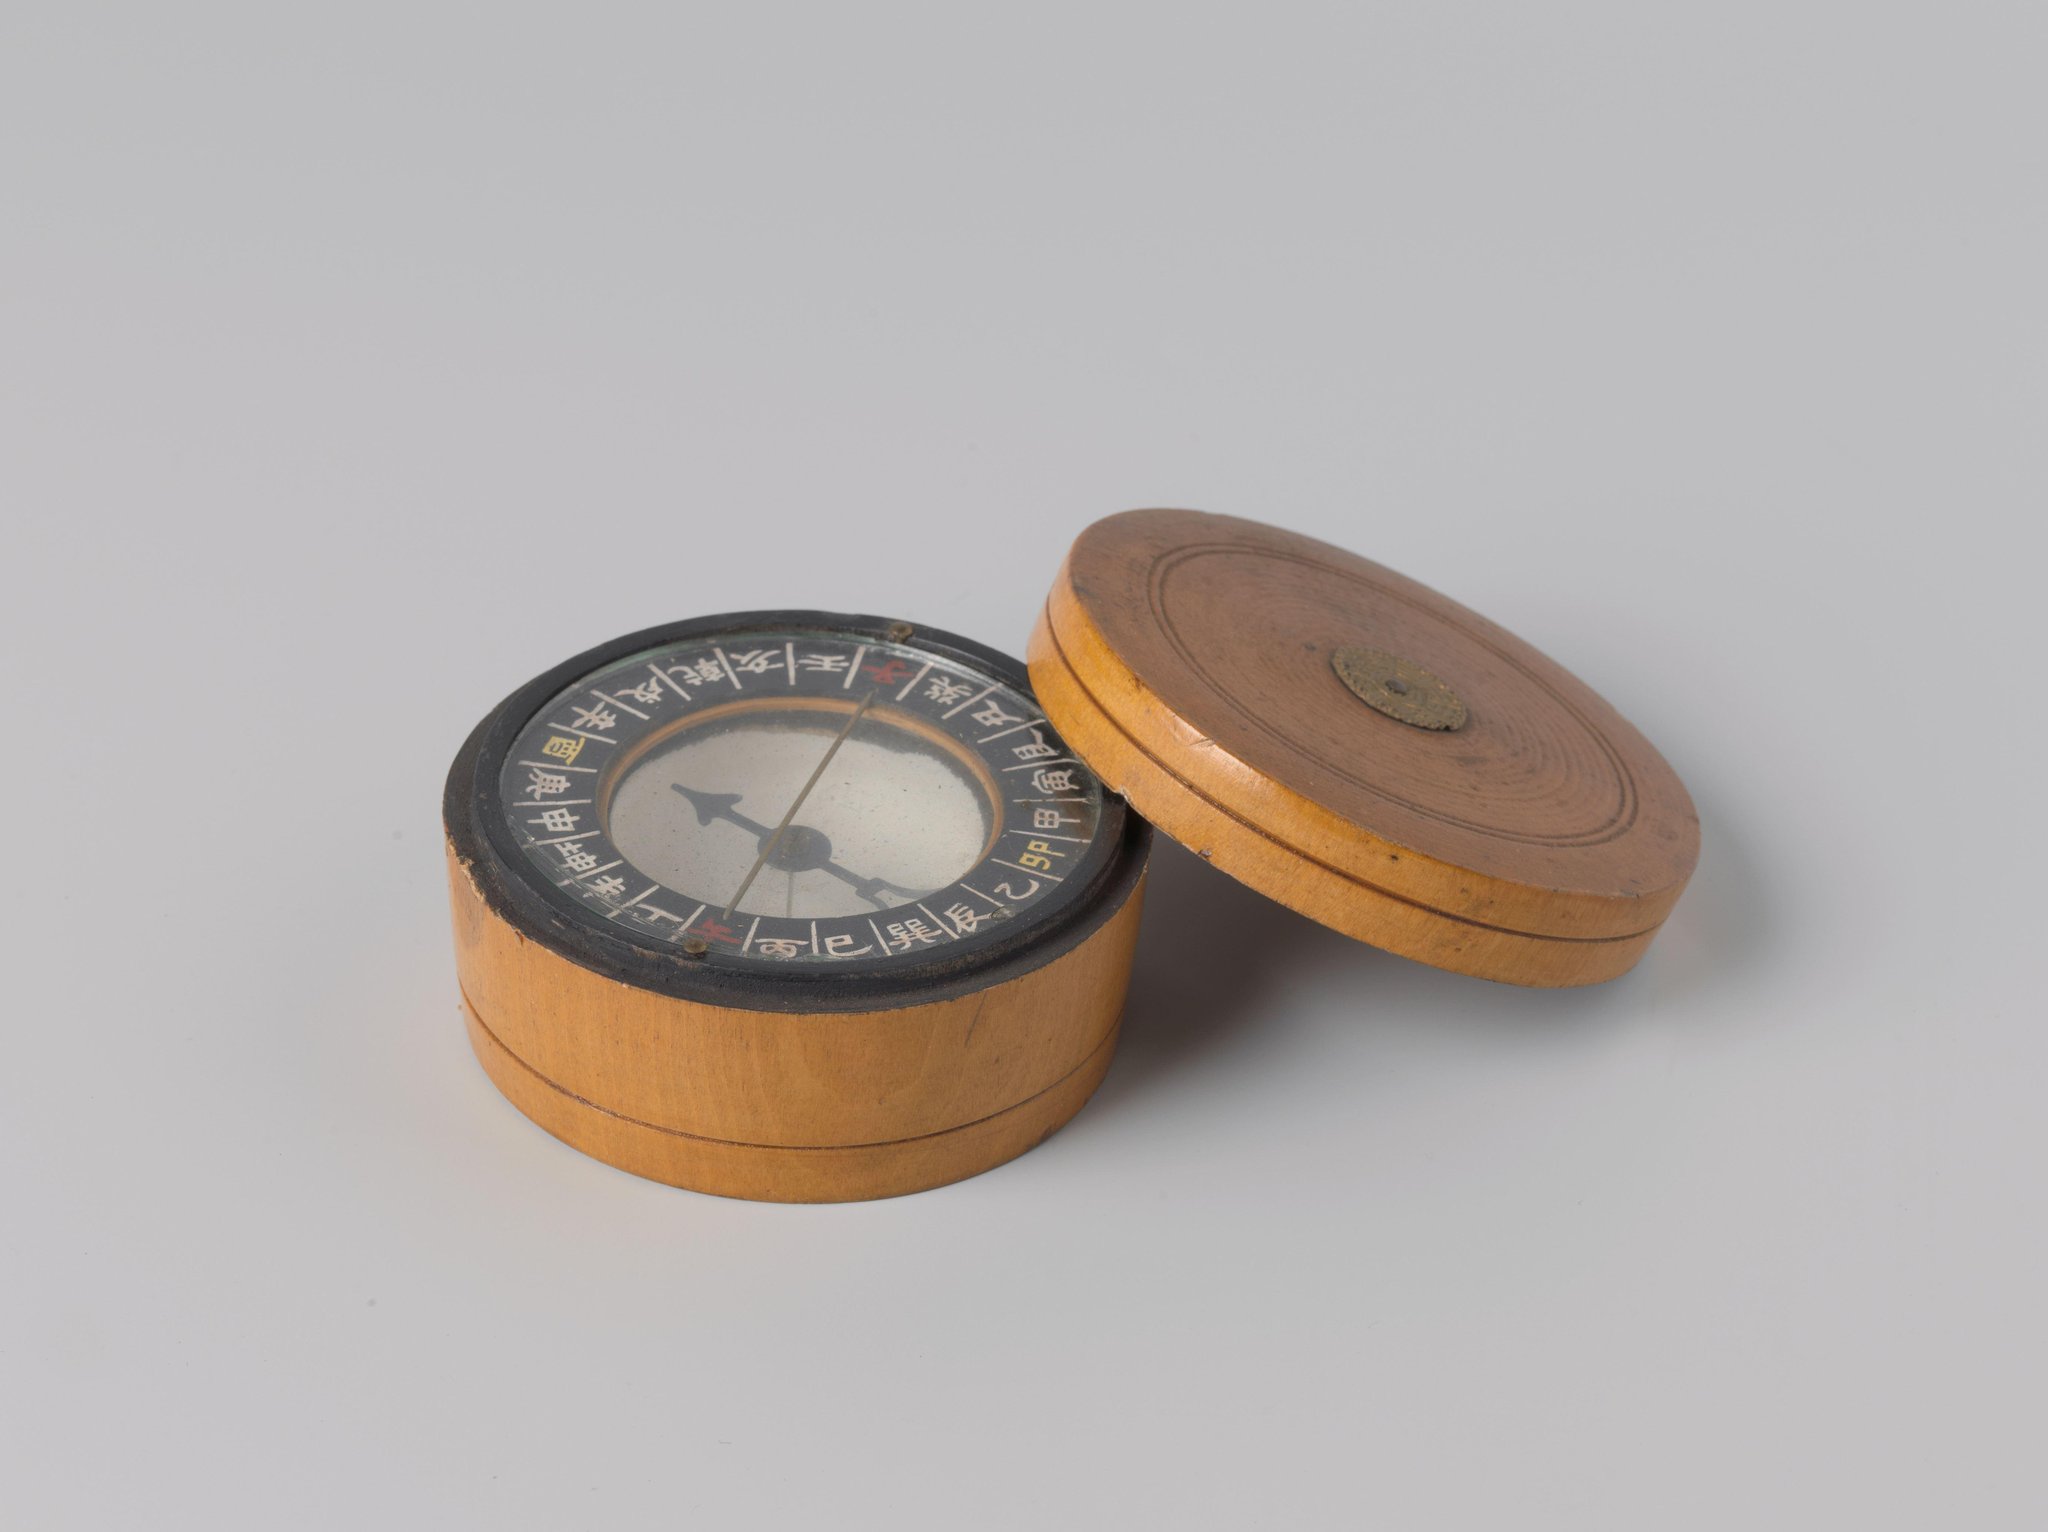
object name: compass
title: Chinese Compass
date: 1850-1899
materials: copper, glass, metal, wood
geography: yantai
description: Chinees kompas bestaand uit een kom, aan de binnenzijde wit beschilderd en bedekt met glas, met daarin een droge kompasnaald. Chinese kompassen kennen een onderverdeling in 24 windrichtingen. De windrichtingen zijn weergegeven in witte karakters, noord en zuid zijn weergegeven in rood, oost en west in geel. Noord-zuid wordt tevens weergegeven door een metalen draad.